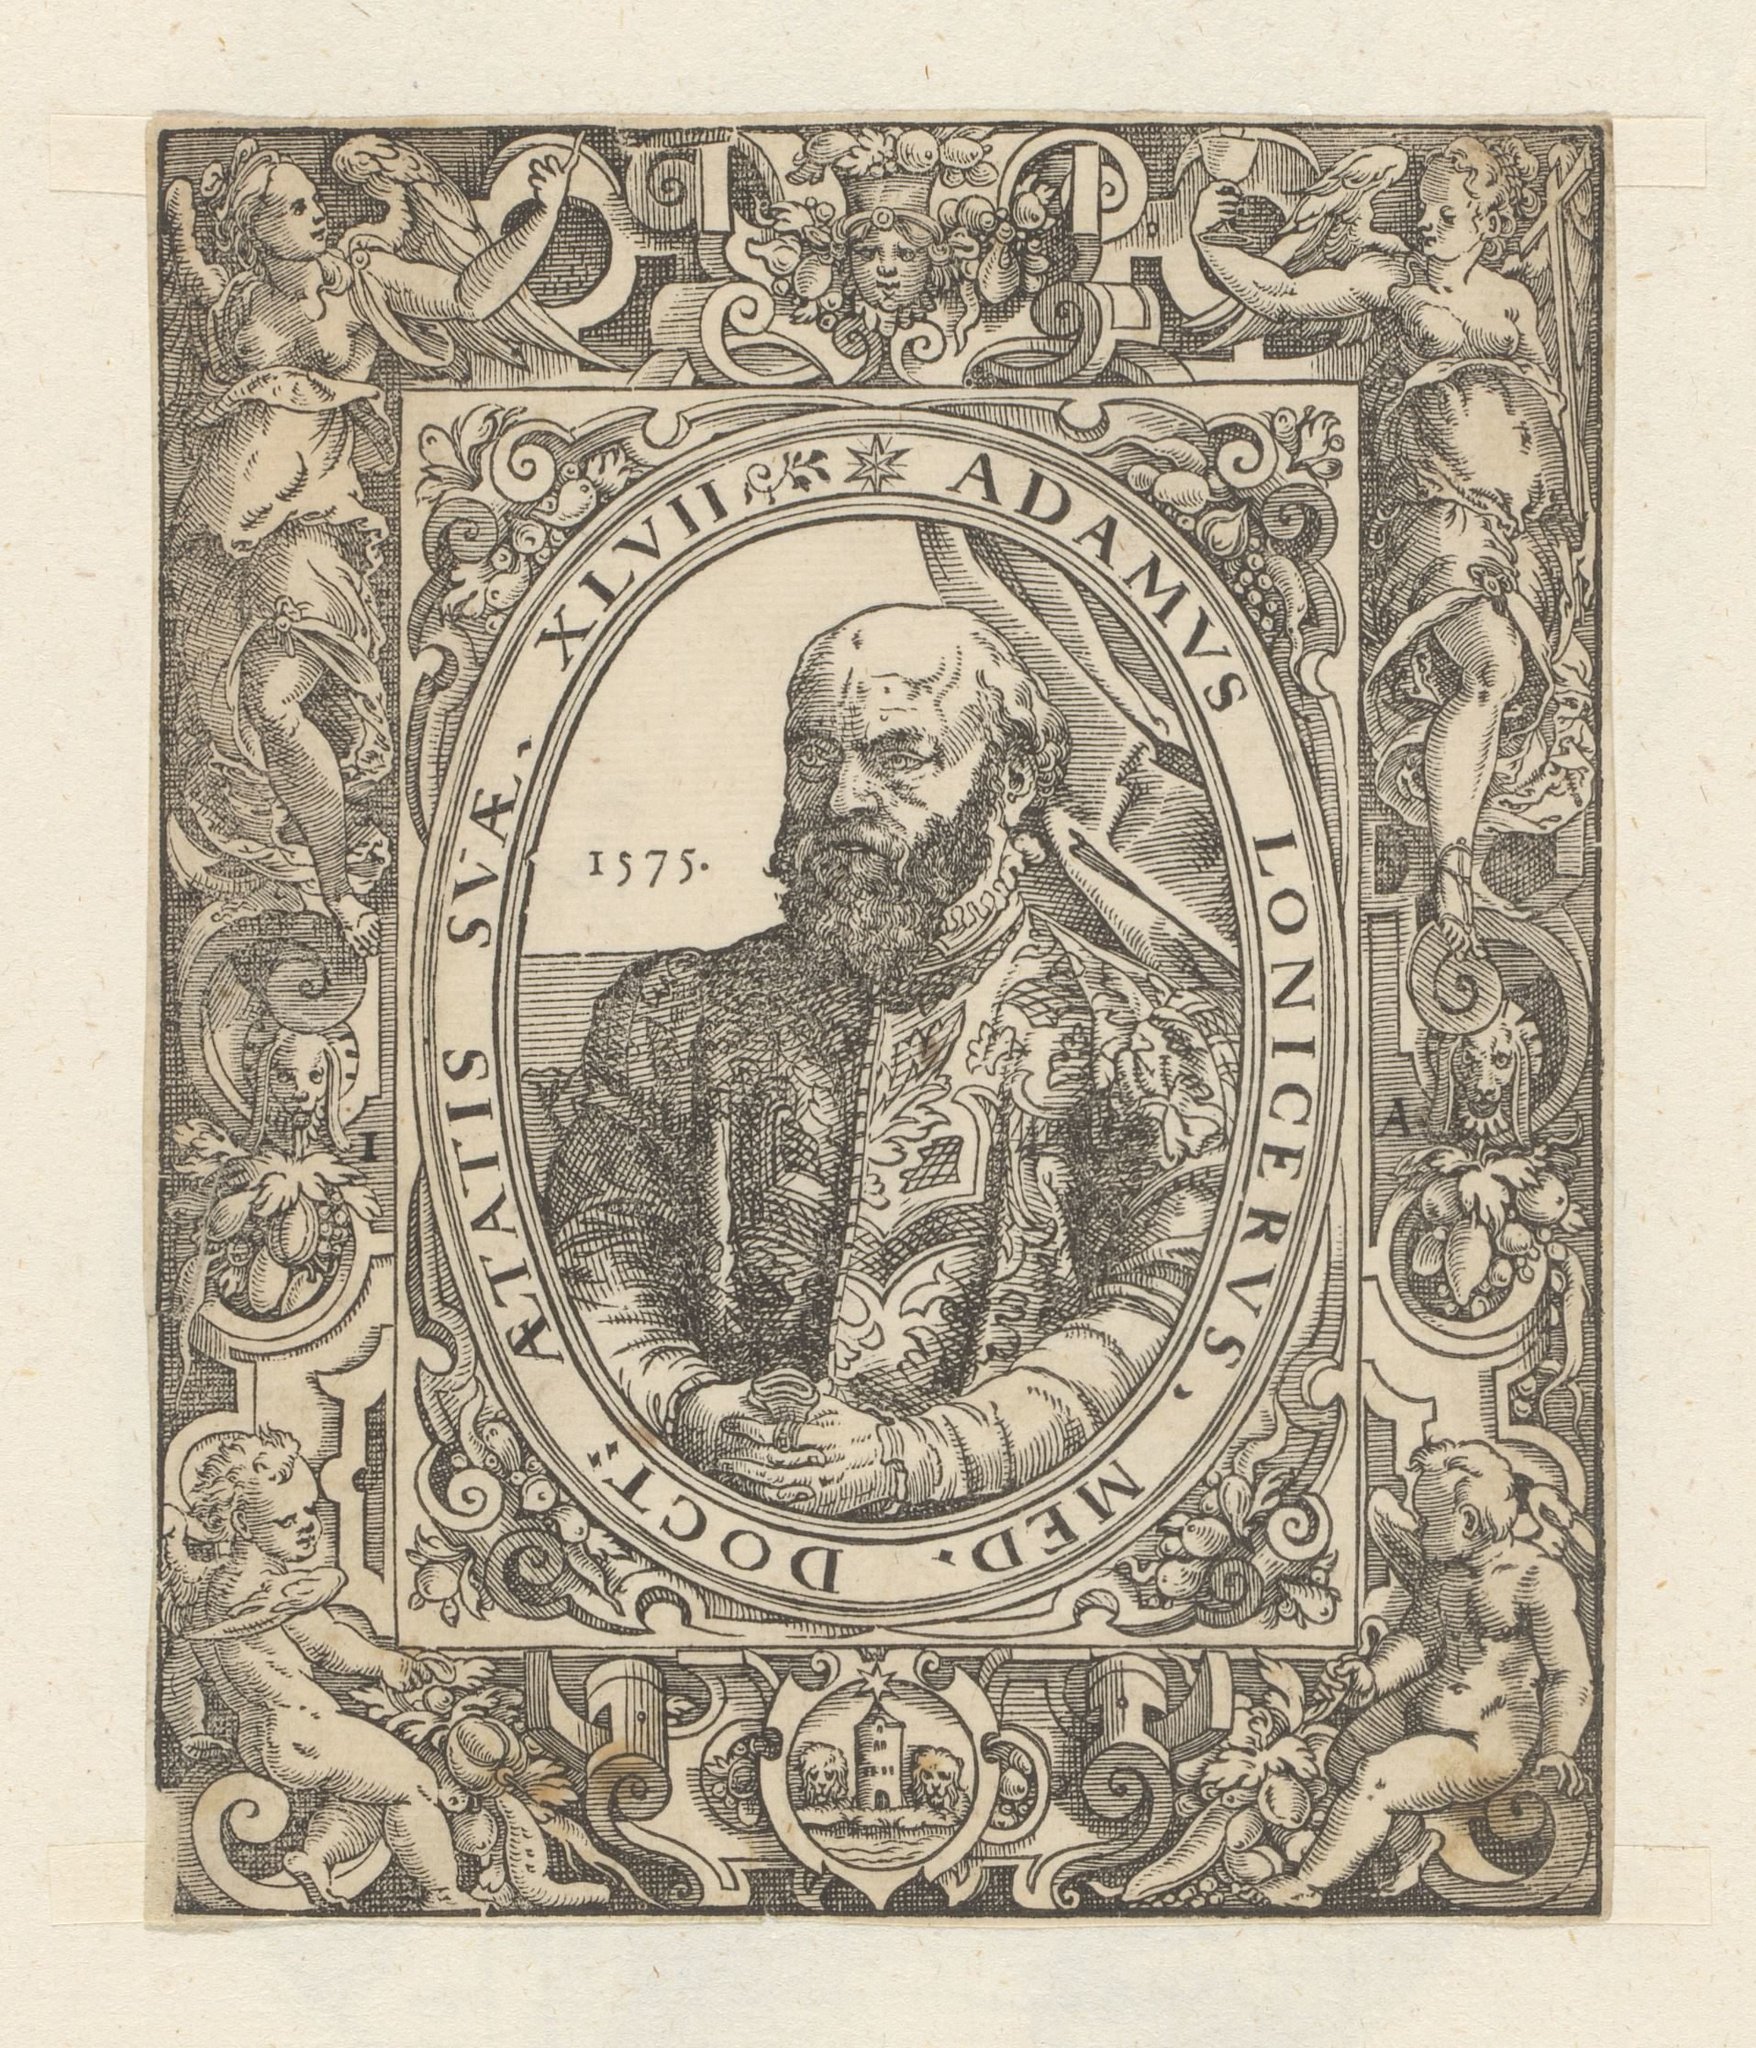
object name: book illustration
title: Portret van Adam Lonitzer op 47-jarige leeftijd met ornamentele omkadering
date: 1575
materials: paper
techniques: woodcut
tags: botany (+ portrait of scholar, scientist), historical persons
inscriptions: date